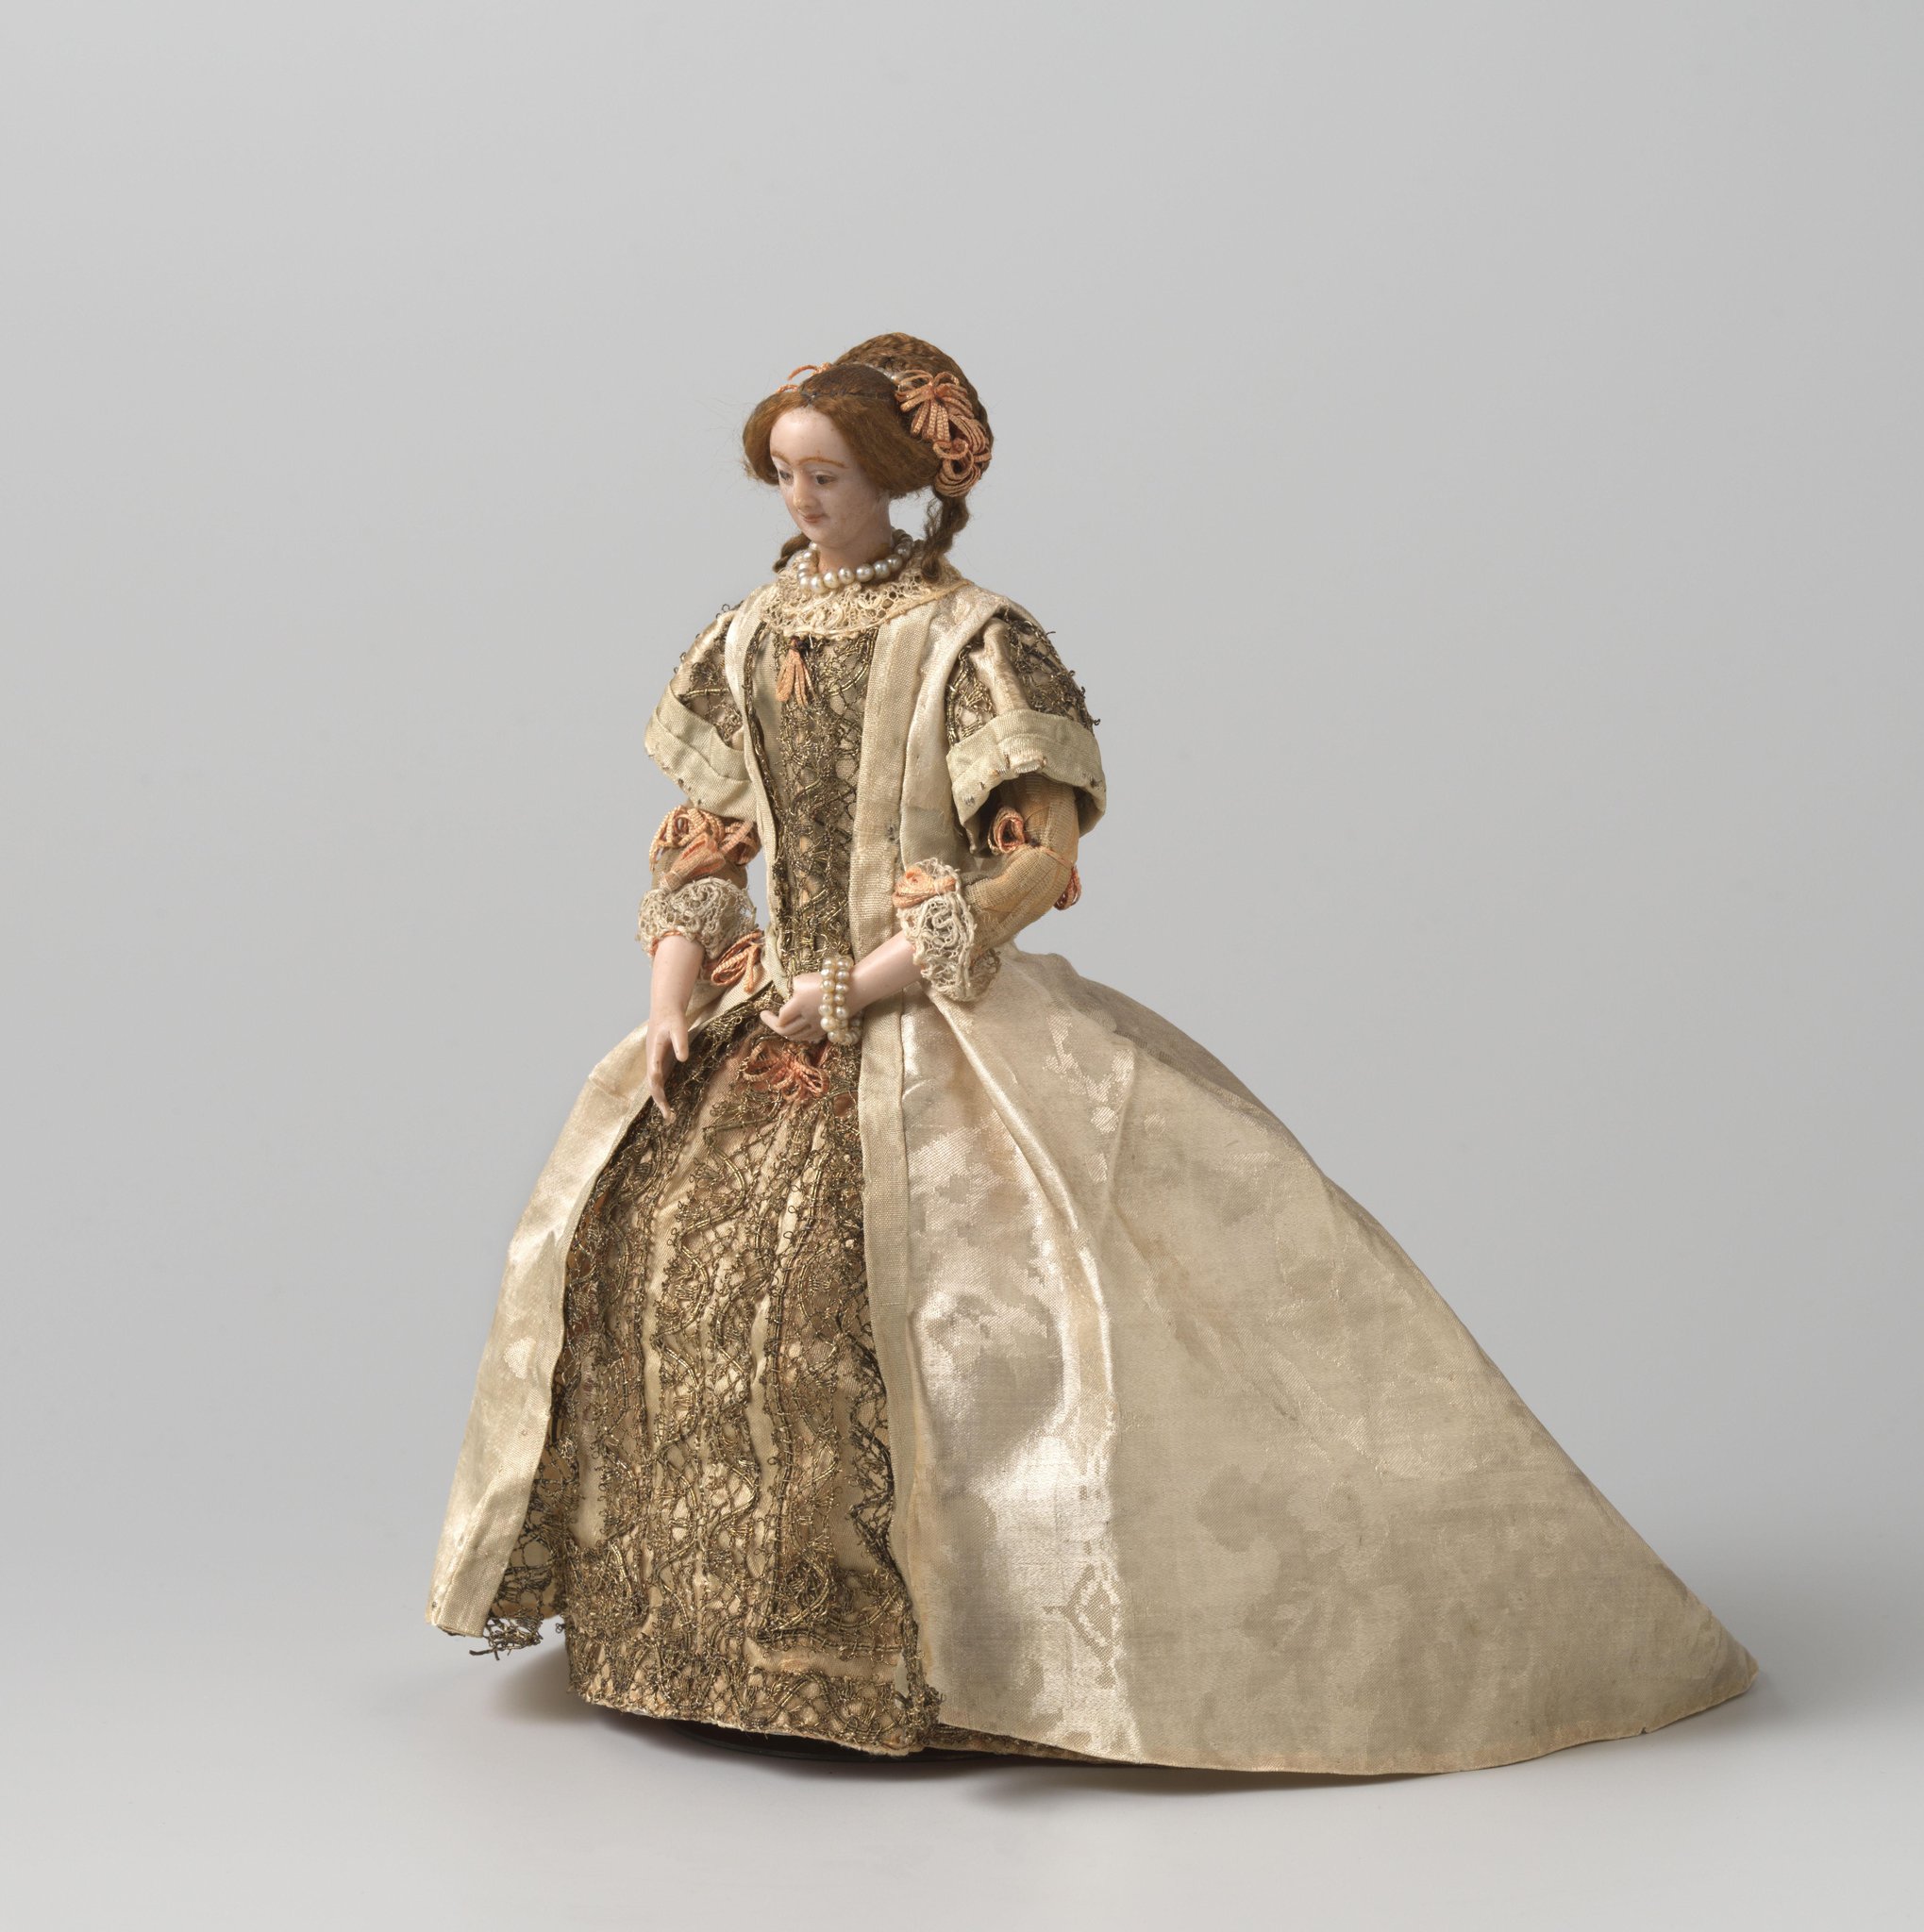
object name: doll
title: Pop, voorstellende een juffrouw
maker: Anonymous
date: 1676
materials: textile, hair, leather, linen, metal, pearl, silk, fiber, wax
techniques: lace, damask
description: Pop, voorstellende een juffrouw, gekleed in een japon bestaande uit drie delen, een borststuk van effen crème zijde, een rok van effen oorspronkelijk roze-rood gekleurde satijn, waarover de overjapon met korte mouwen van crèmekleurige zijdedamast.